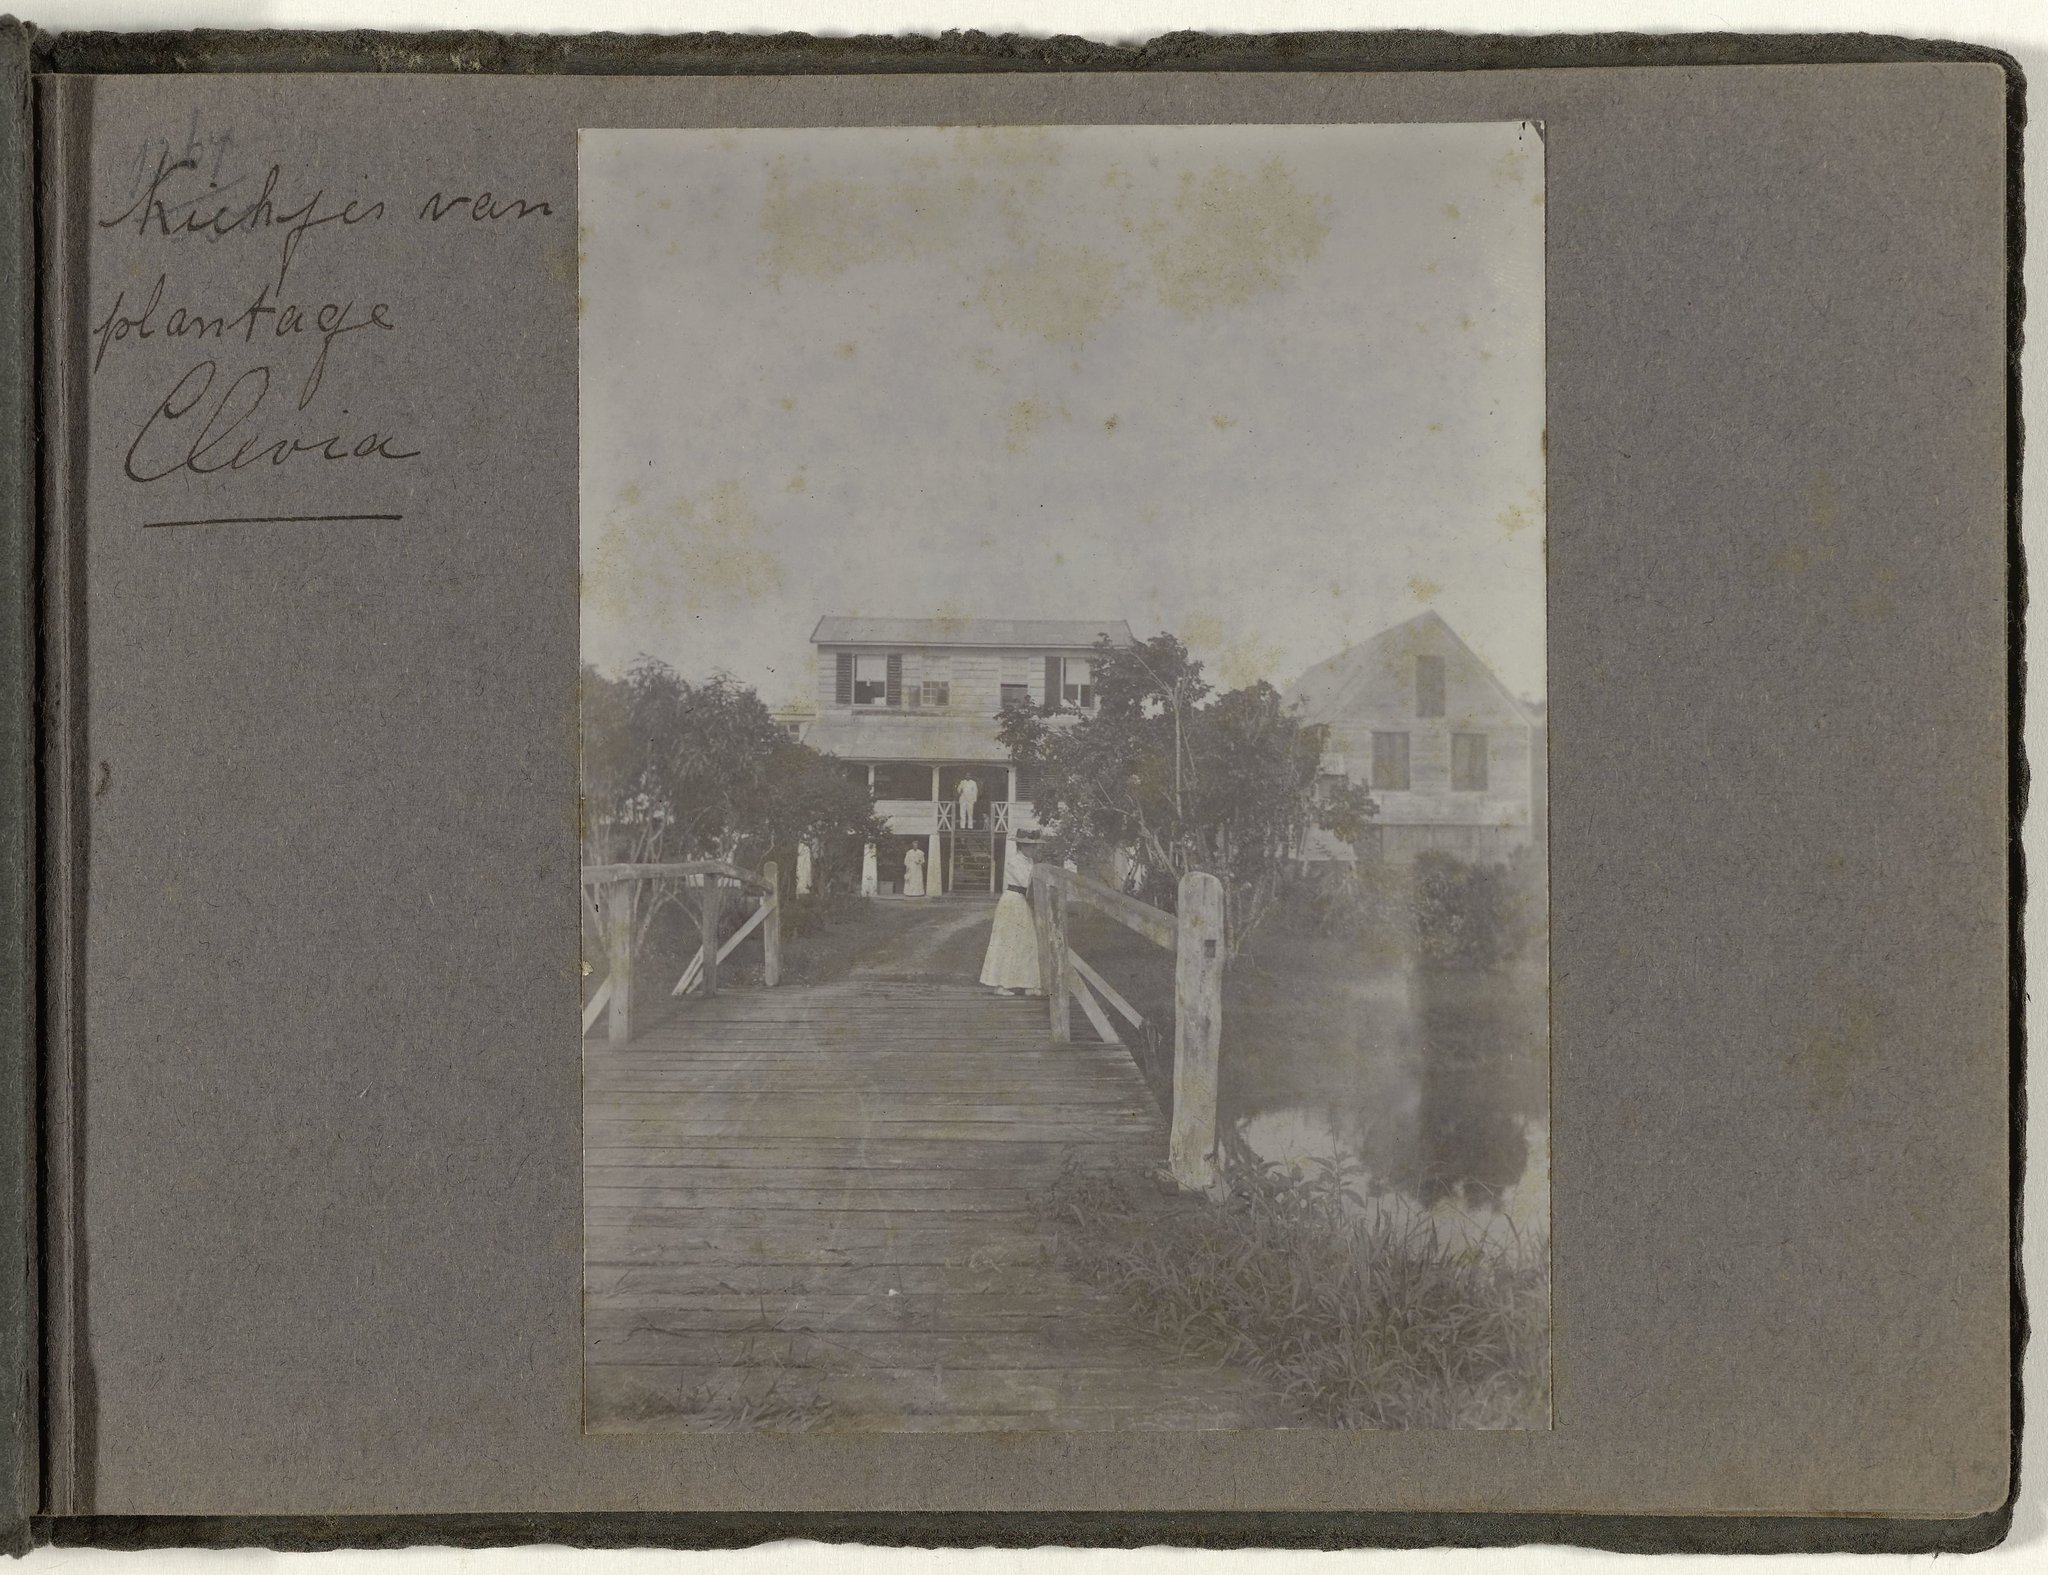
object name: photograph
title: Woningen op plantage Clevia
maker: Anonymous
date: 1910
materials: photographic support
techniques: gelatin silver print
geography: suriname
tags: plantation, suriname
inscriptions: inscription: ‘Kiekjes van plantage Clevia’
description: Houten brug naar enkele gebouwen op de plantage Clevia. Op de brug staat een jonge vrouw. Onderdeel van het fotoalbum over de familie Gonggrijp op de plantages Clevia en Morgenstond in Suriname rond 1910.